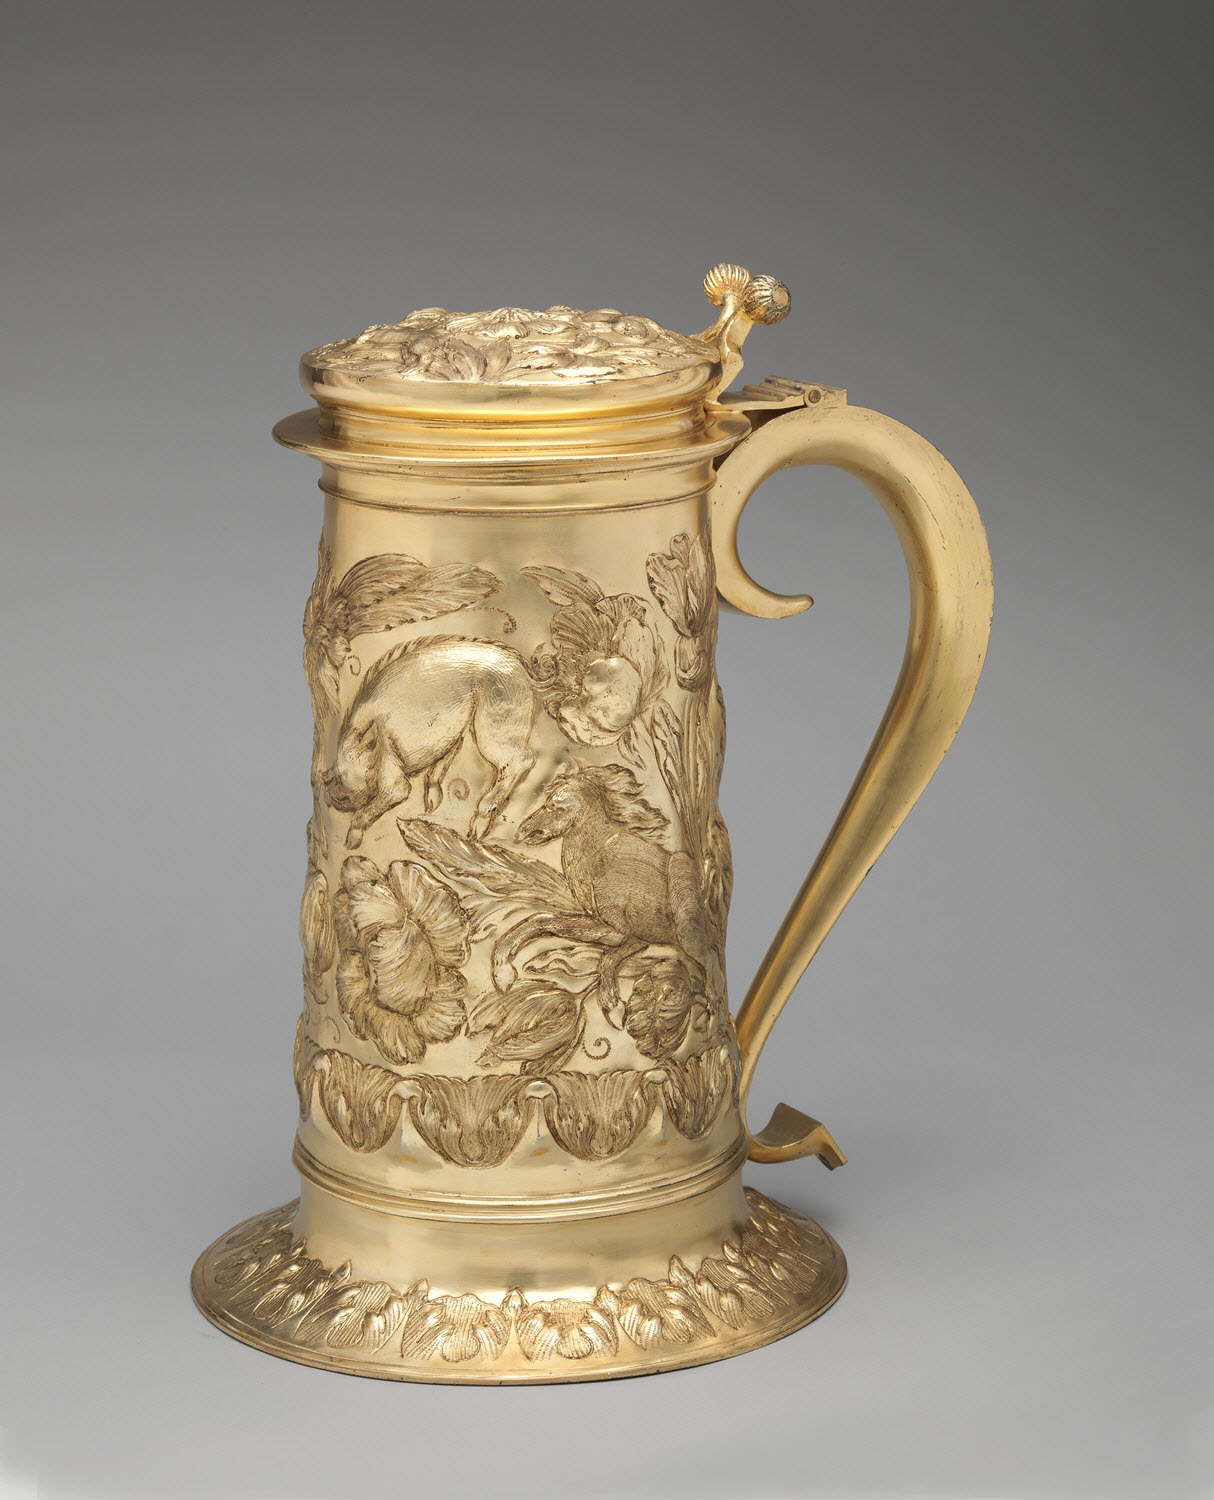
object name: flagon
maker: elkington & co.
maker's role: manufacturer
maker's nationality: british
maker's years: 1829-1963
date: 1801-1900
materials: metal, silver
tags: animals,horses,flowers